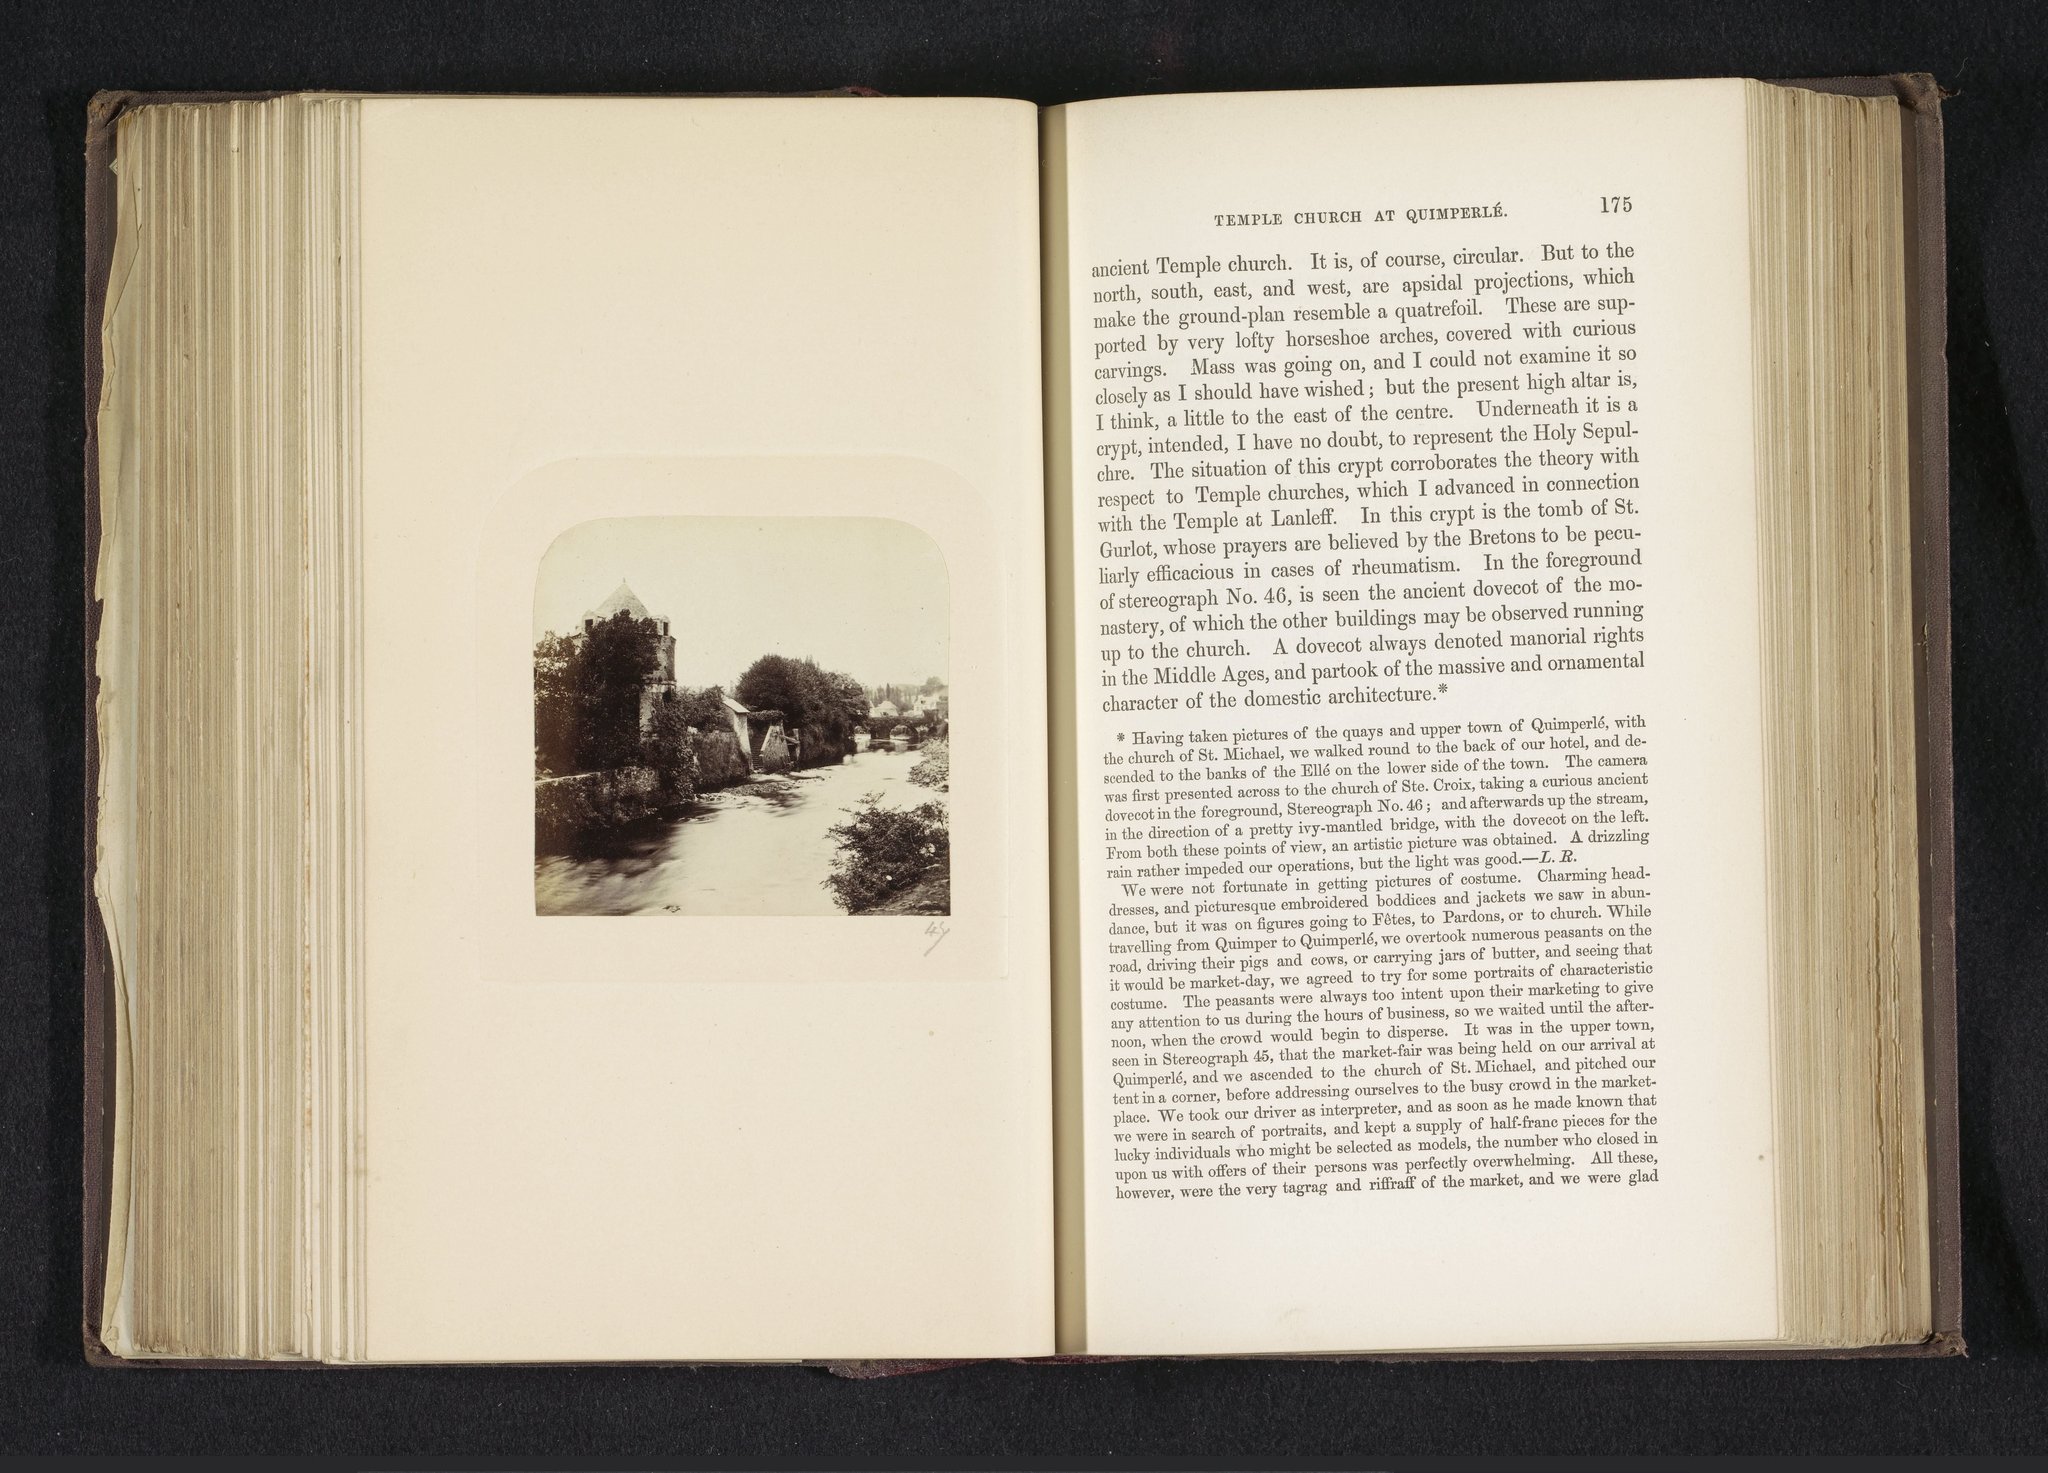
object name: page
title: Gezicht op de Ellé in Quimperlé met rechts een oude duiventoren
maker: taylor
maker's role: fotograaf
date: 1850-1859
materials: photographic support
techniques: albumen print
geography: quimperlé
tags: river (+ landscape with figures, staffage)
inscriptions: number: ‘47’